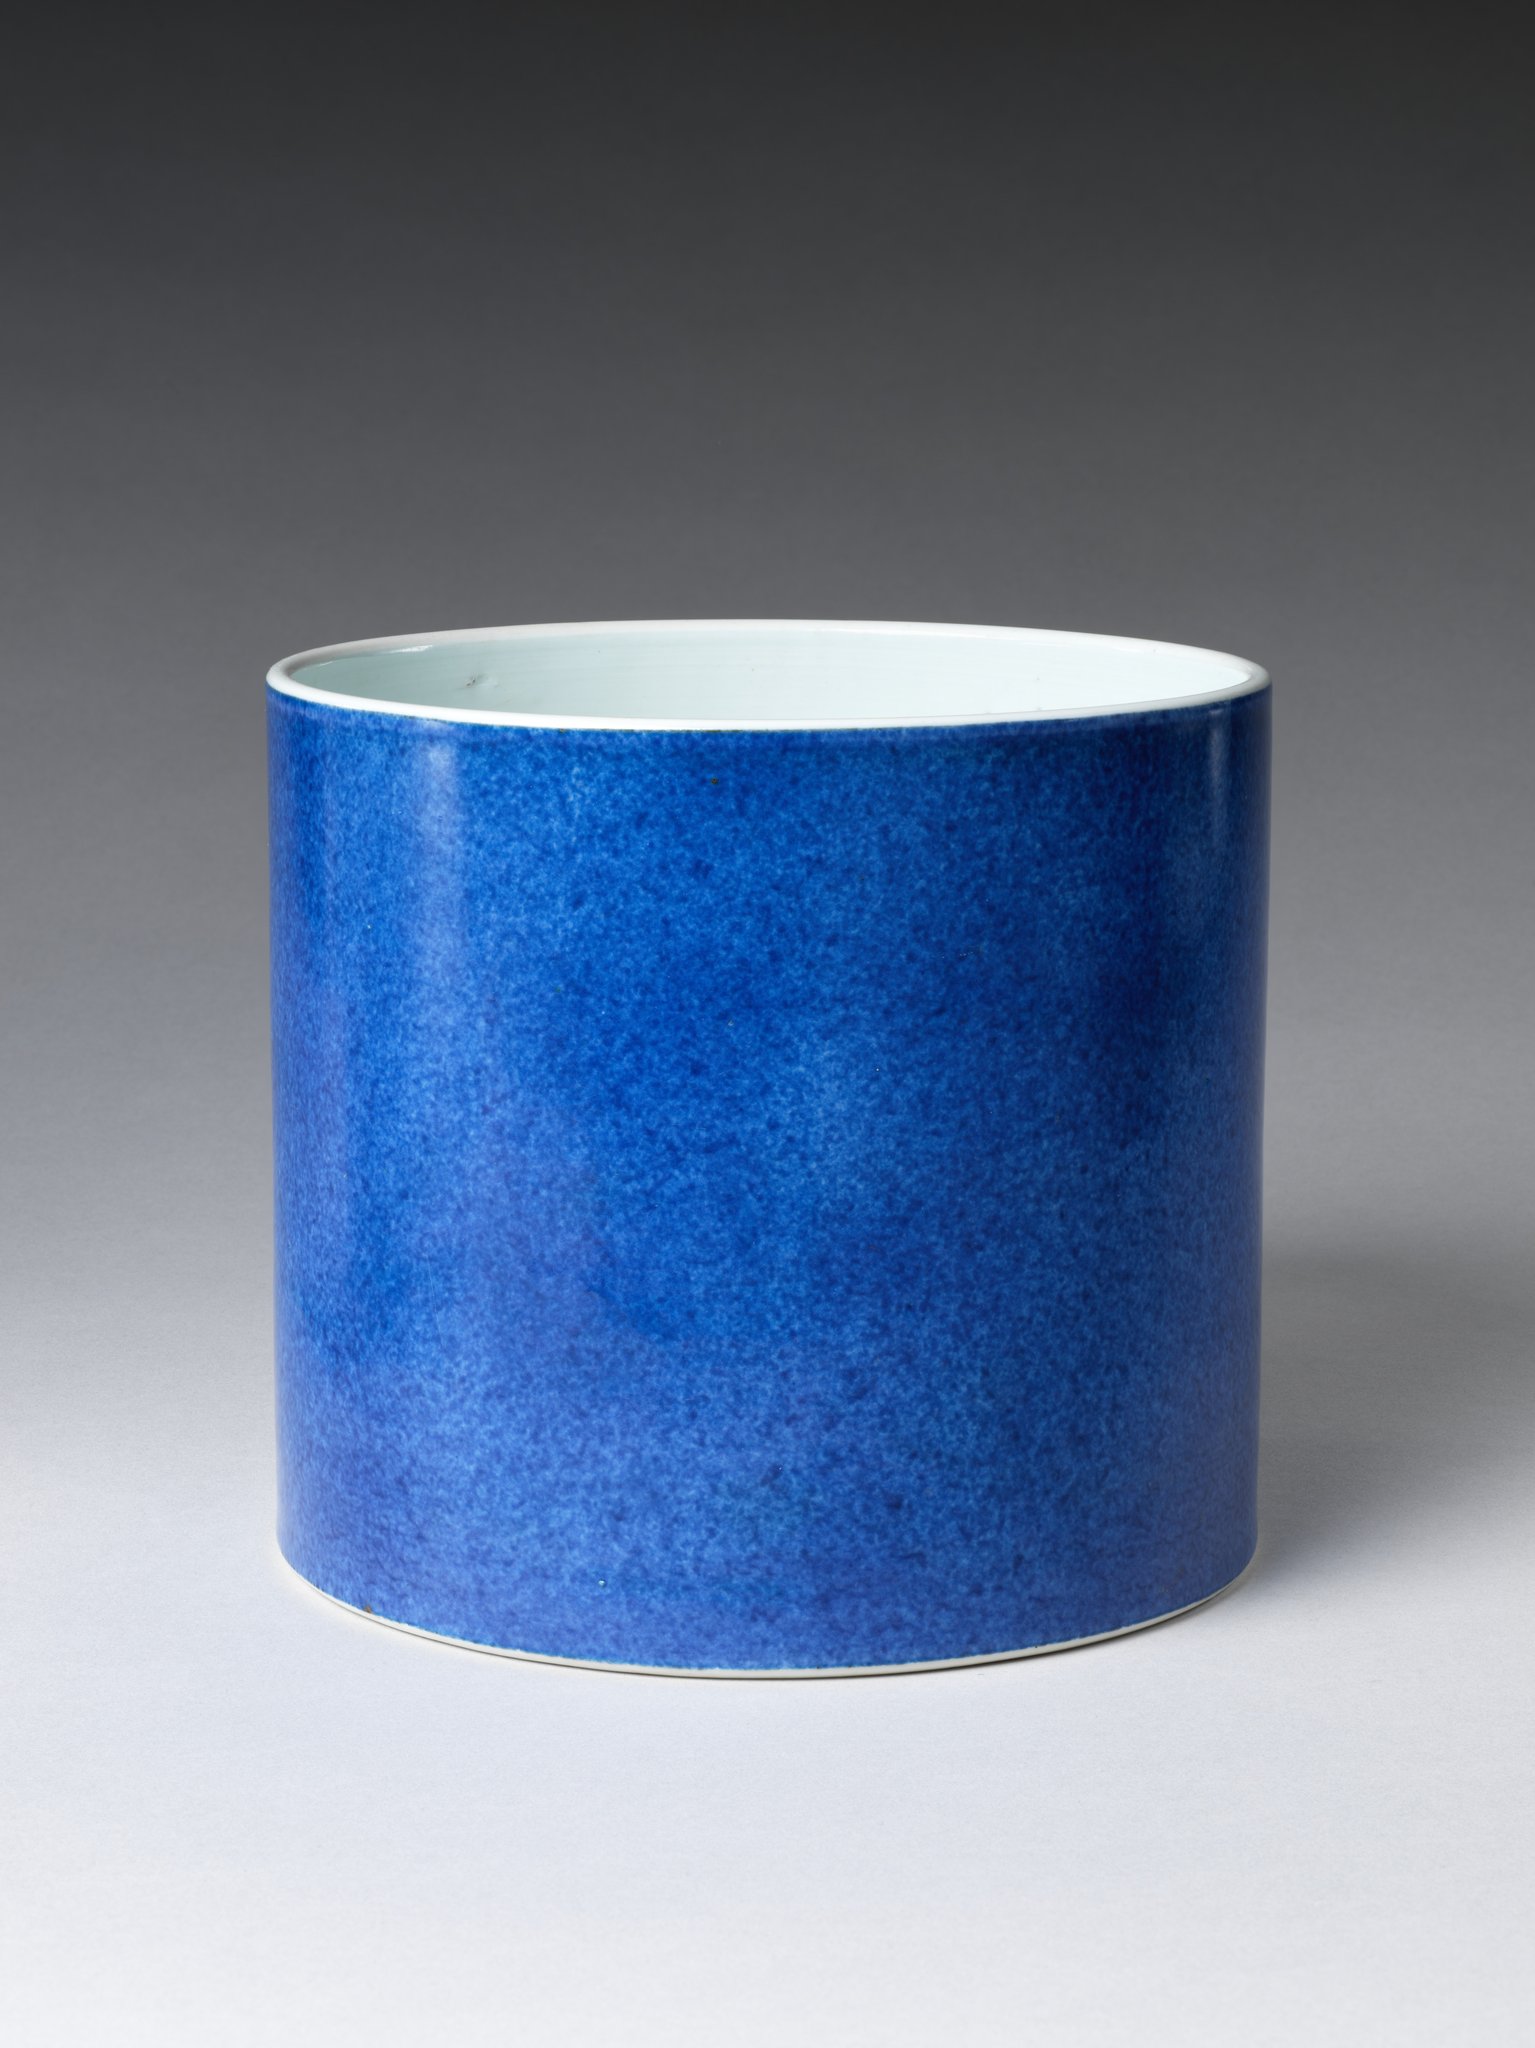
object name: brush holder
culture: chinese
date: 1667-1733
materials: glaze, porcelain